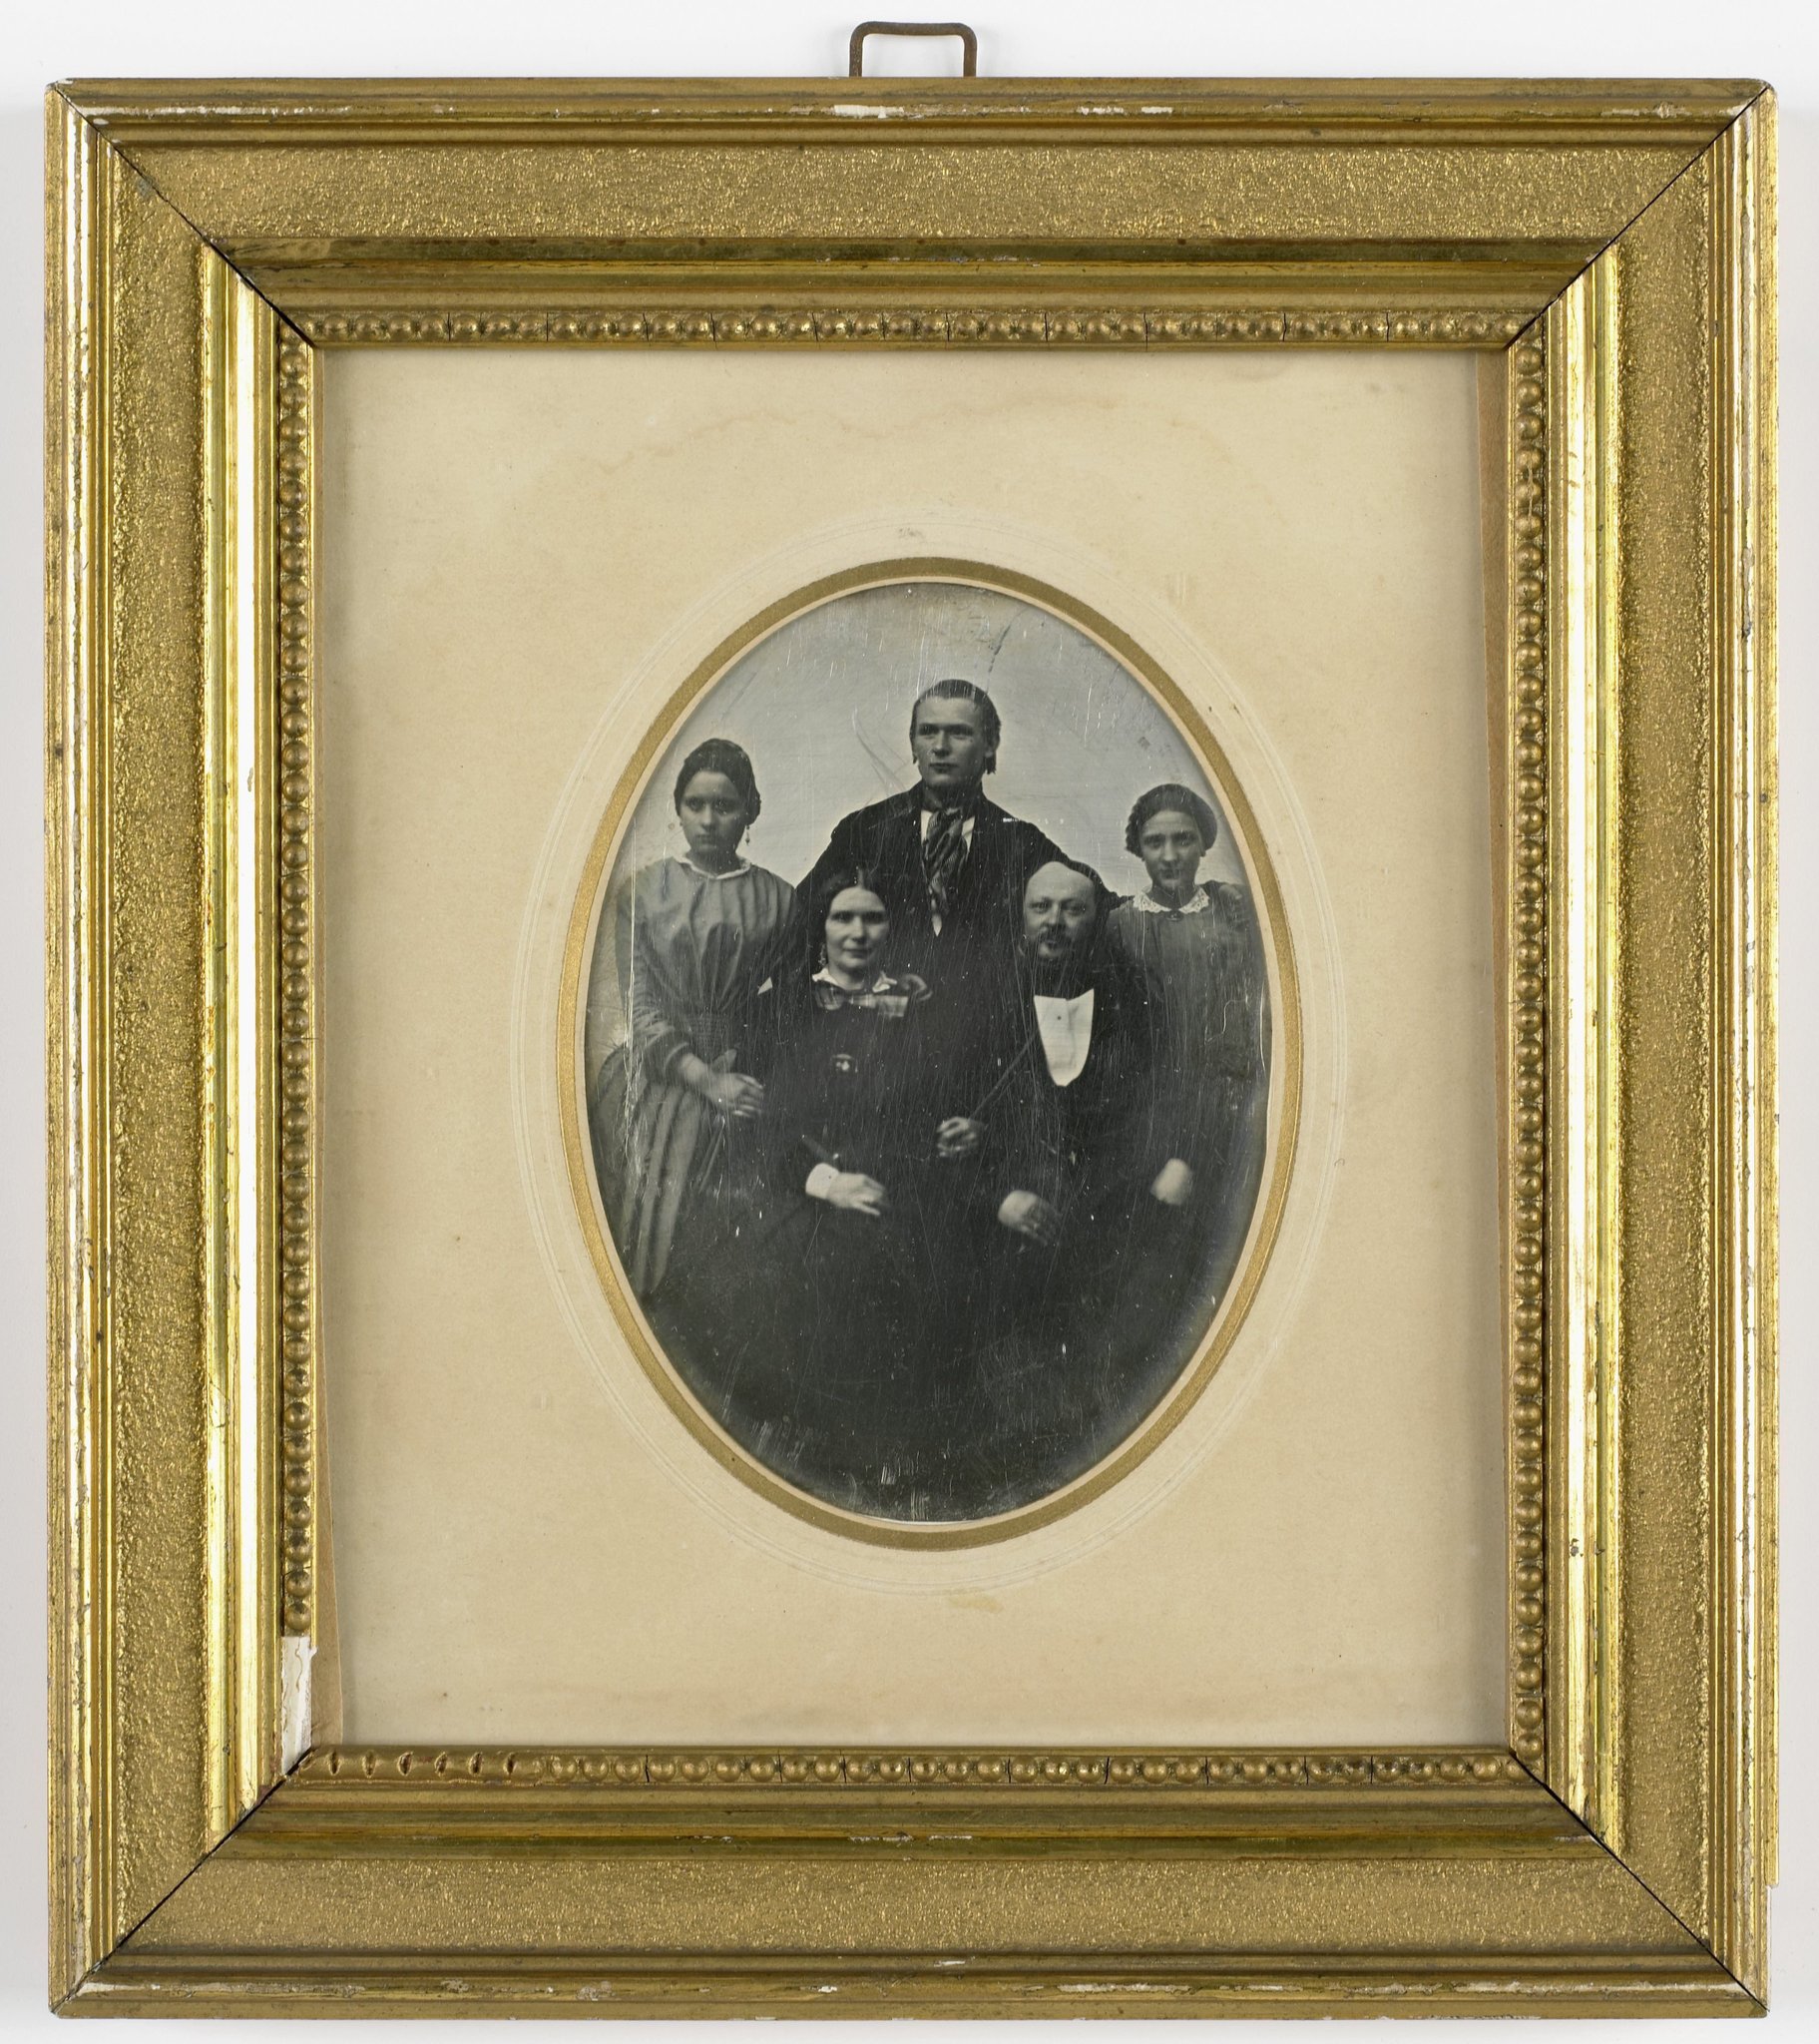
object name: photograph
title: Portret van een onbekend gezin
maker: Anonymous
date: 1855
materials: copper, glass, wood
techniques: daguerreotype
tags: historical persons, family life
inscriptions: inscription: ‘Anoniem/ Daguerreotypie +/- 1855/ 10.1 x18 cm/ zilver [...]/ linksonder 40/ rechtsonder[...]/ gerestaureerd Leiden P.K. 1969/ Thio ureum’